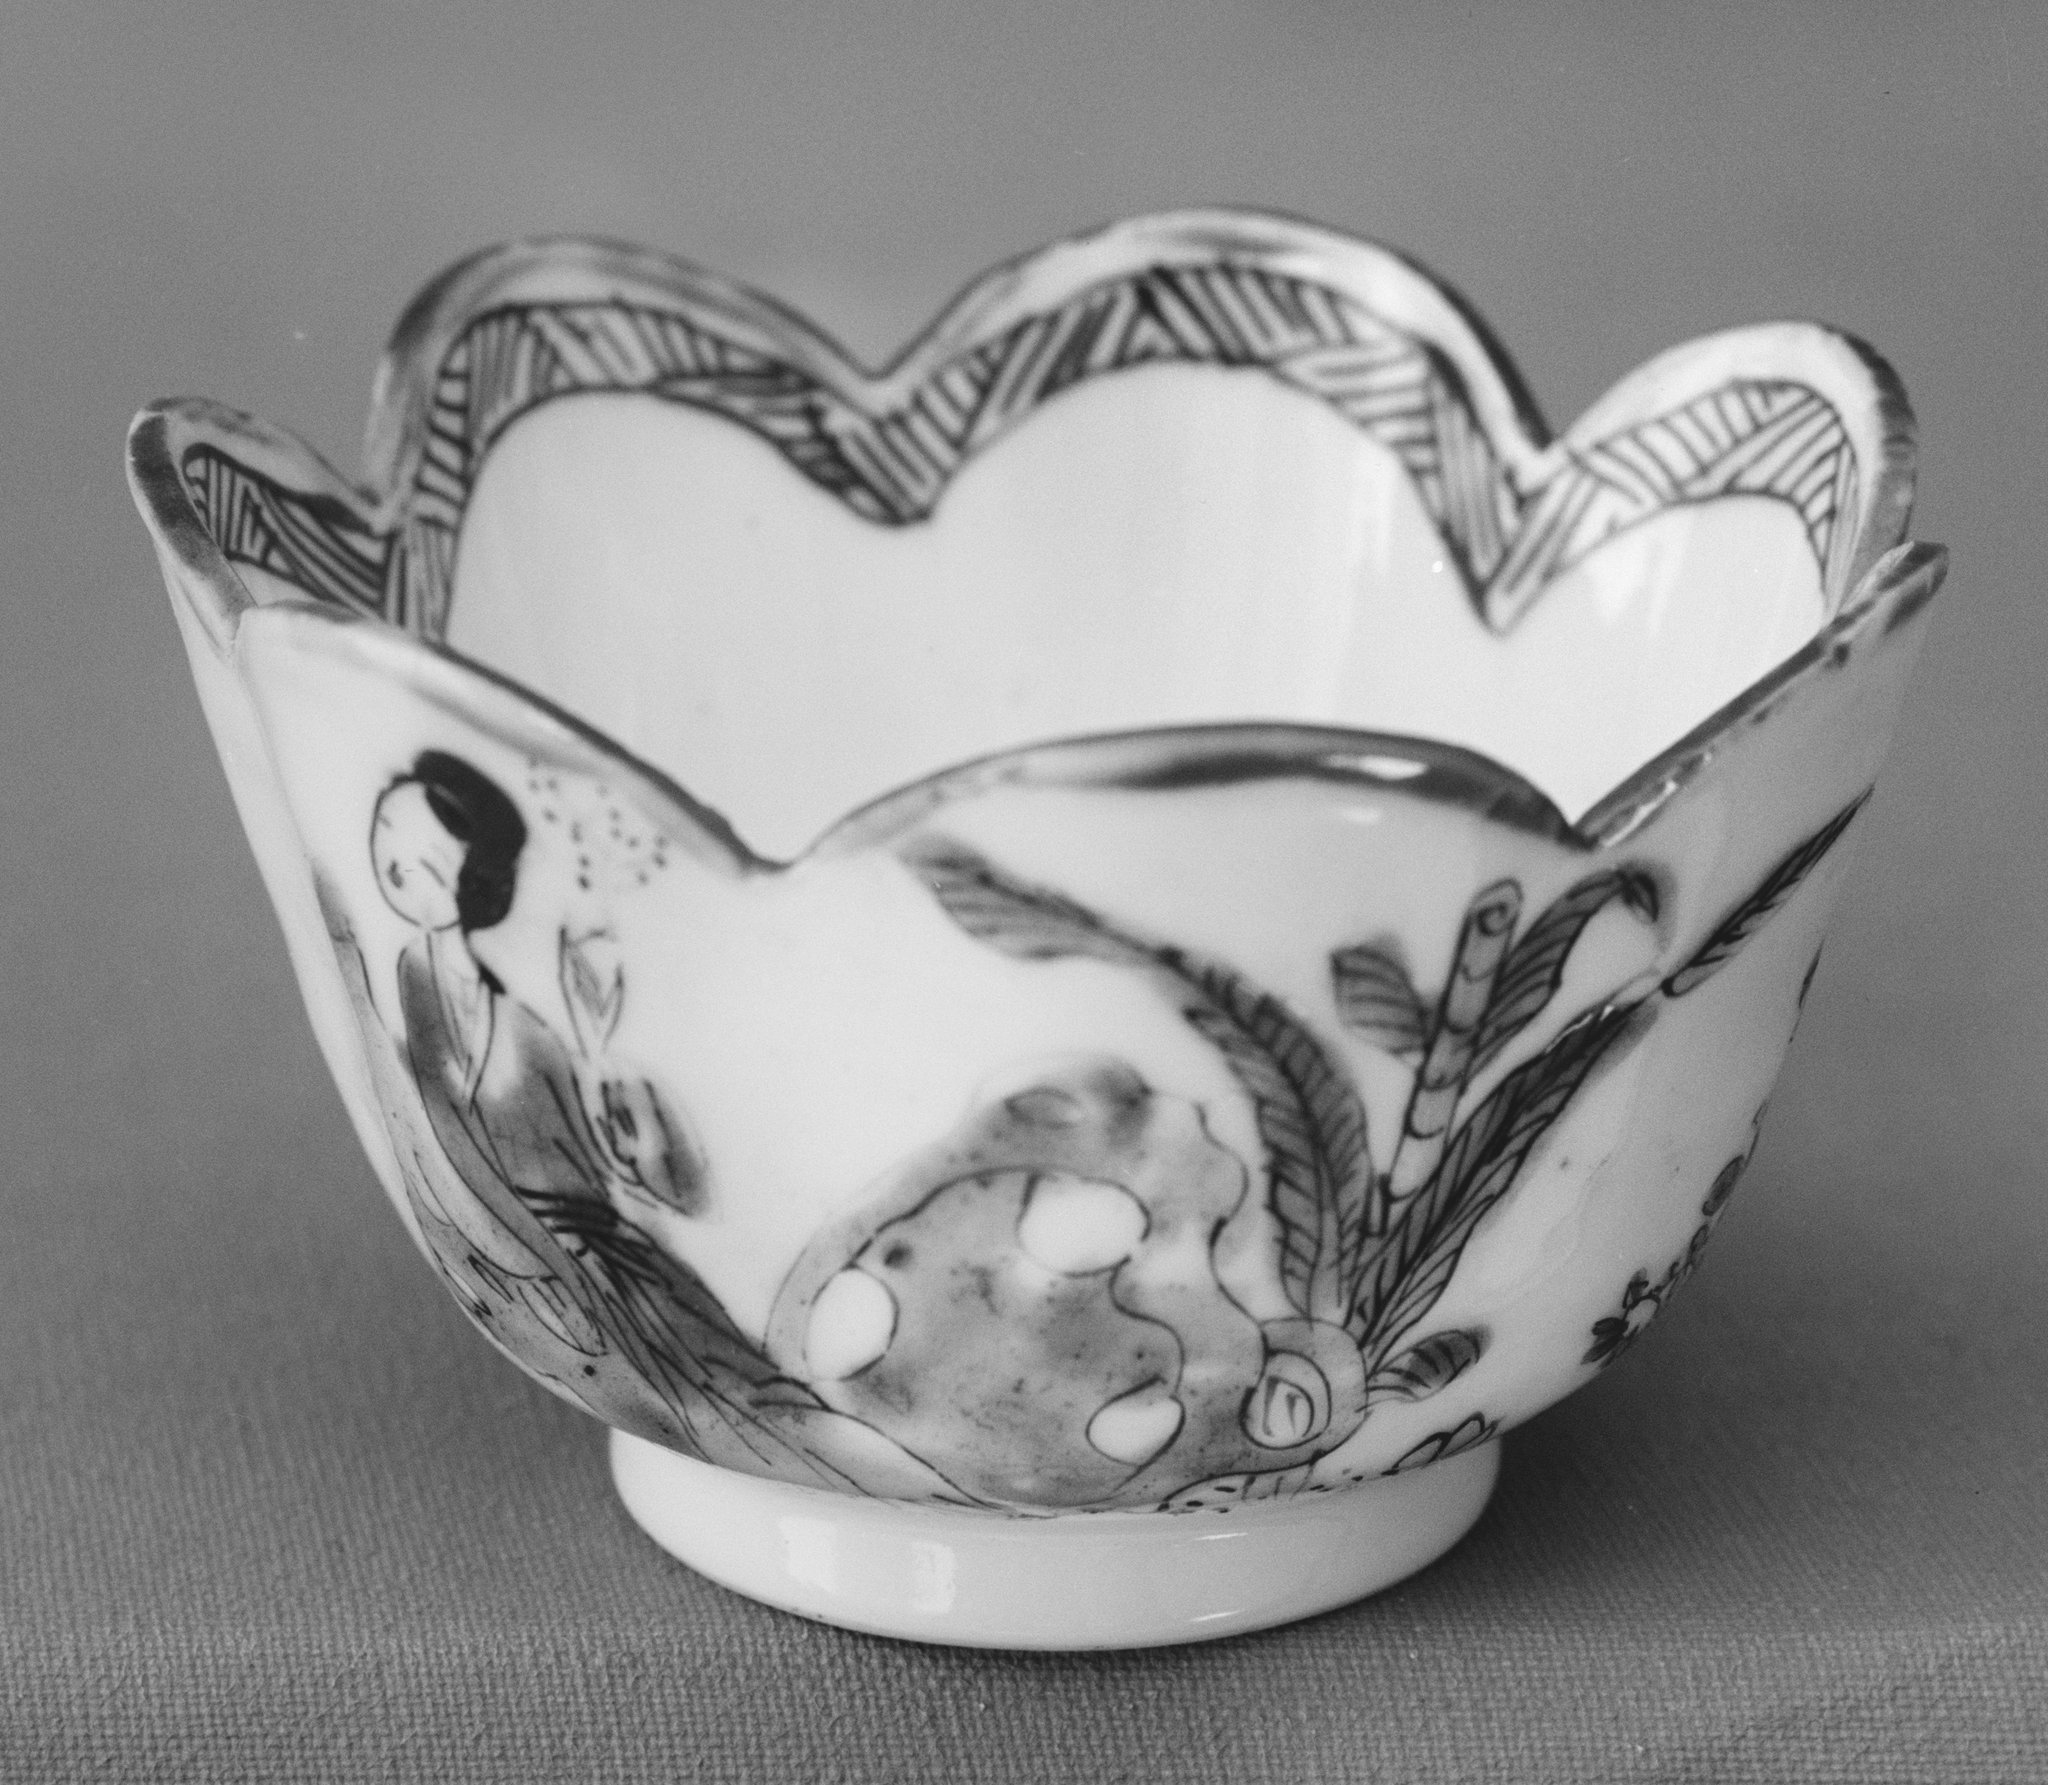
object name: cup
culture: chinese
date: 1801-1850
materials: enamel, porcelain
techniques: overglaze, painting, polychrome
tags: women